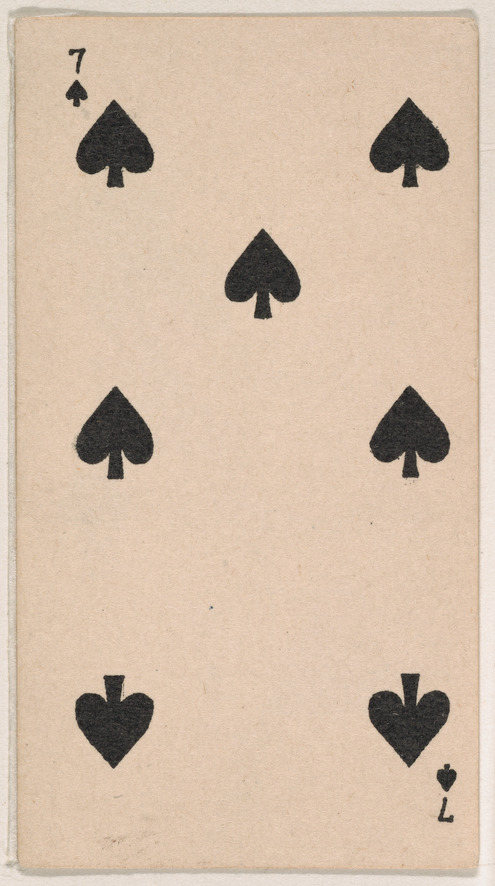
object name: print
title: Seven of Spades, from the Transparent Playing Cards series (N220) issued by Kinney Bros.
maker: kinney brothers tobacco company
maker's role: publisher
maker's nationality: american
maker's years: 1869-2011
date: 1888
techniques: color lithograph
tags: playing cards